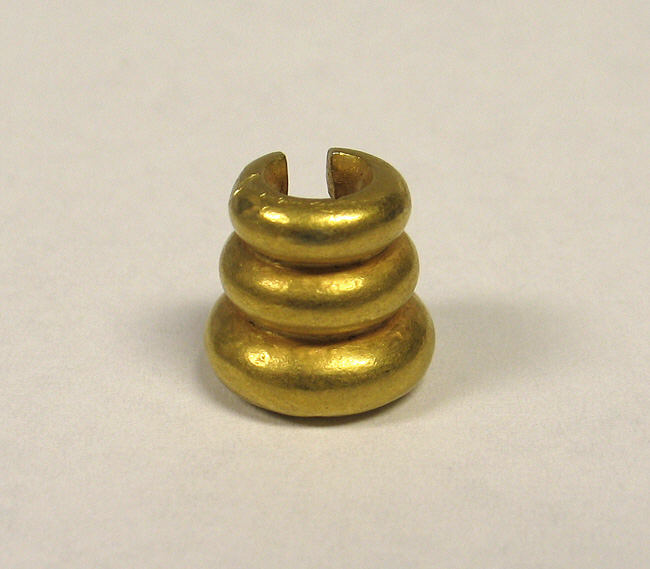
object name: ornament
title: Ornament, Tooth Pattern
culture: indonesian, central java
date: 701-1200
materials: gold